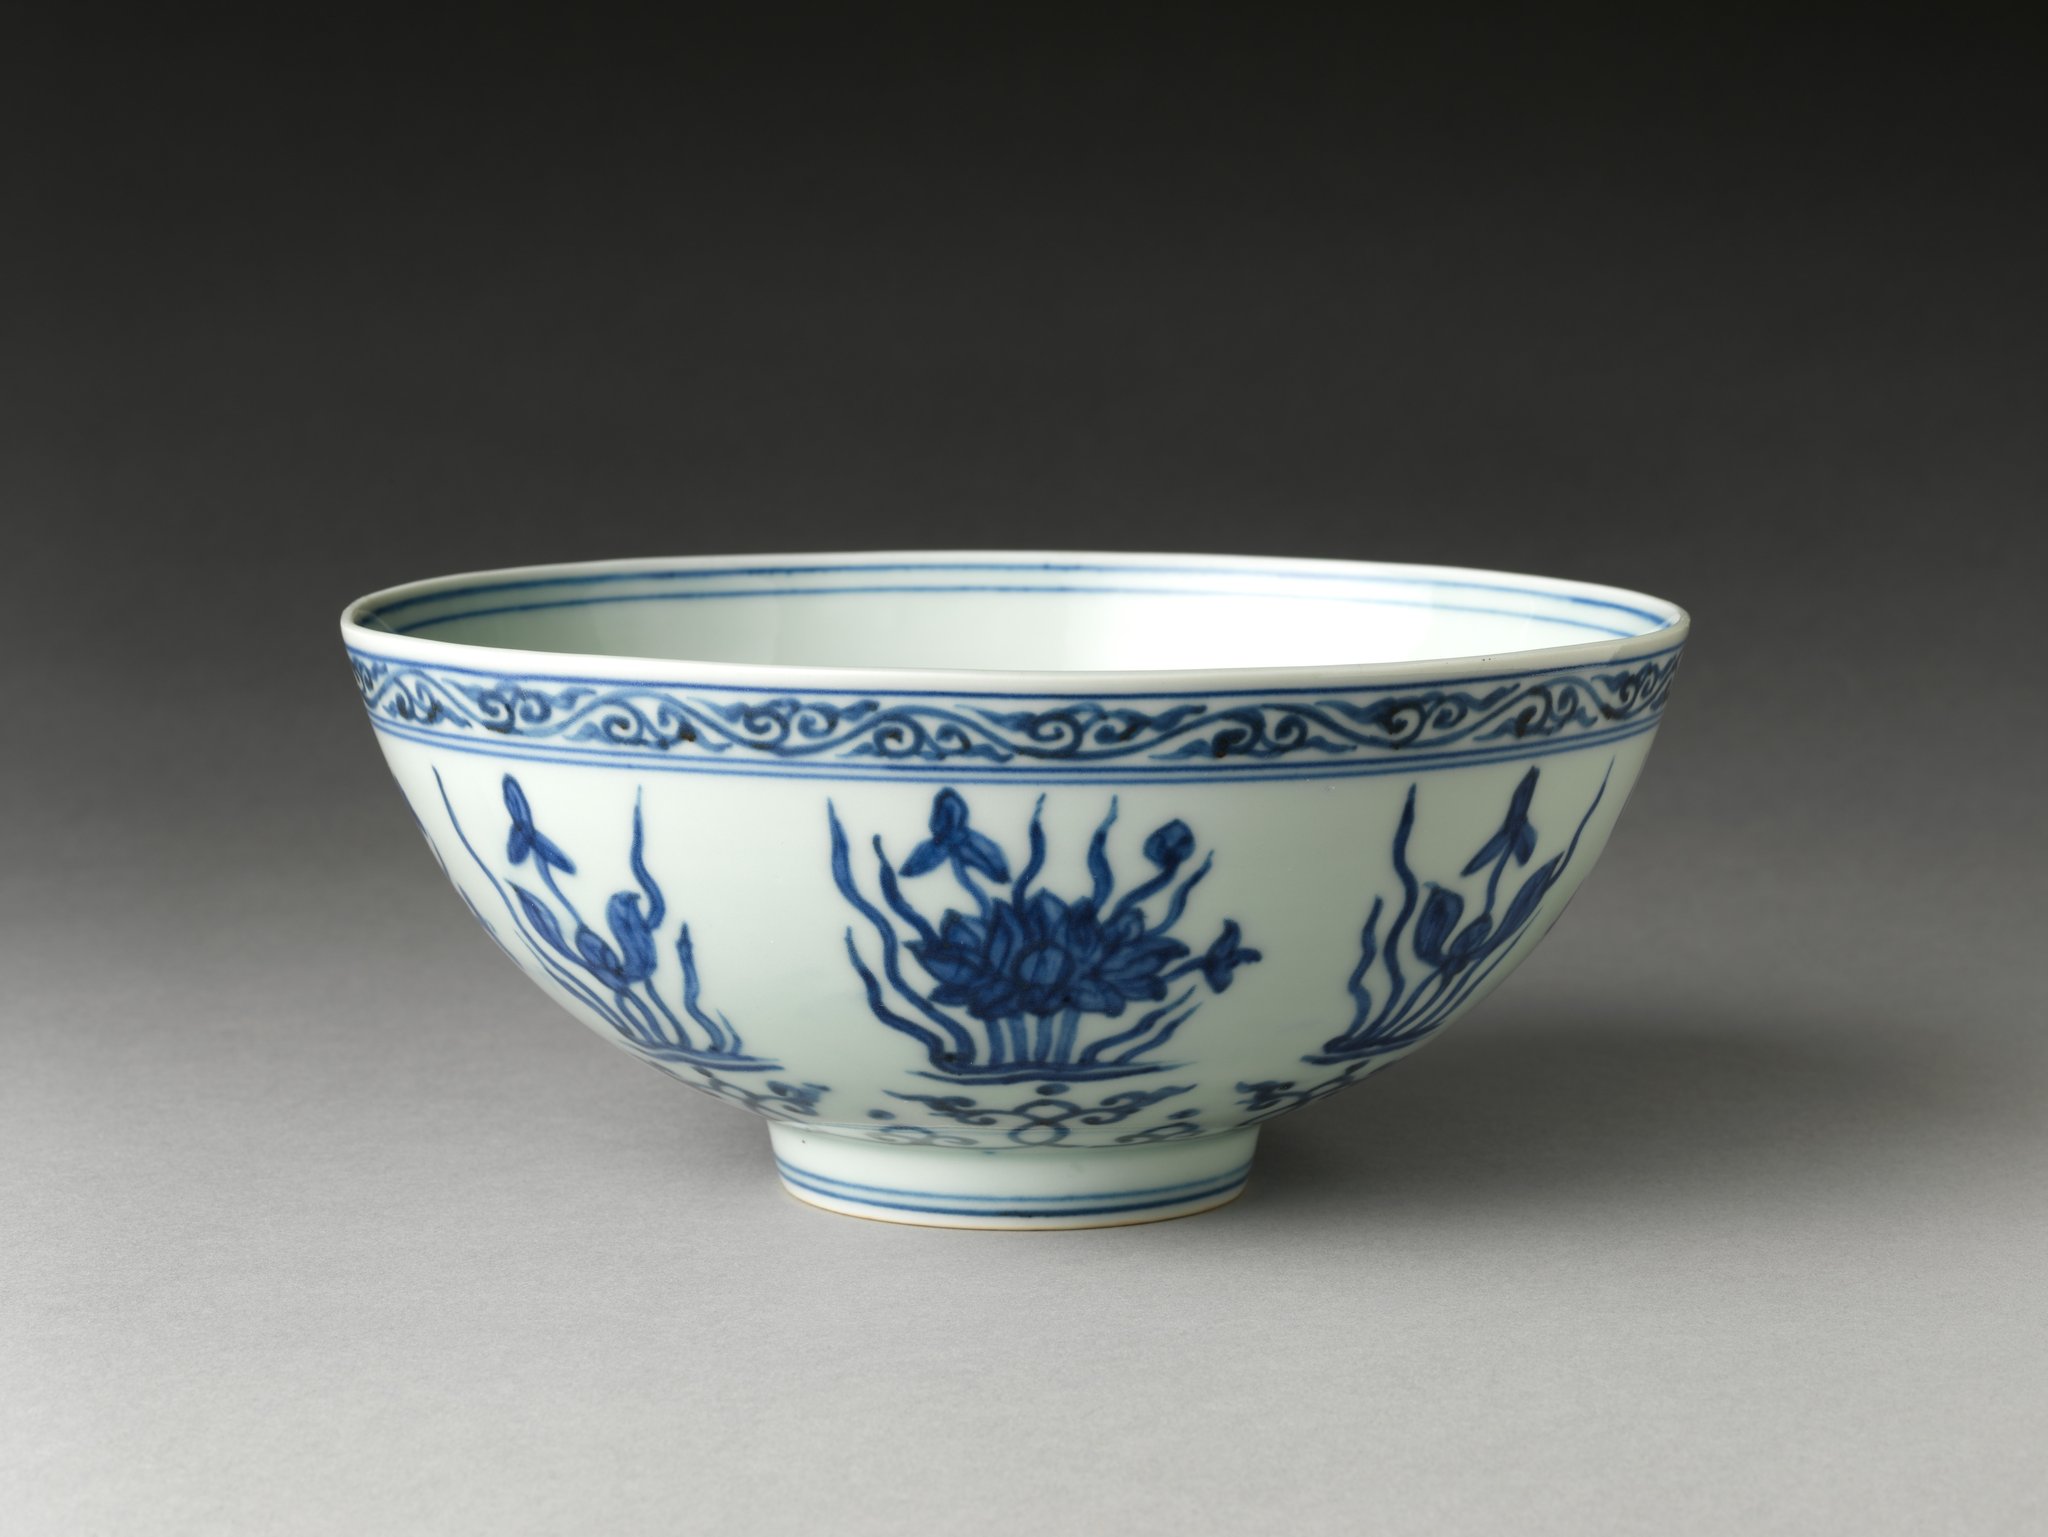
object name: bowl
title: Bowl with Lotuses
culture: chinese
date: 1501-1533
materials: cobalt, glaze, porcelain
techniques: painting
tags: lotuses